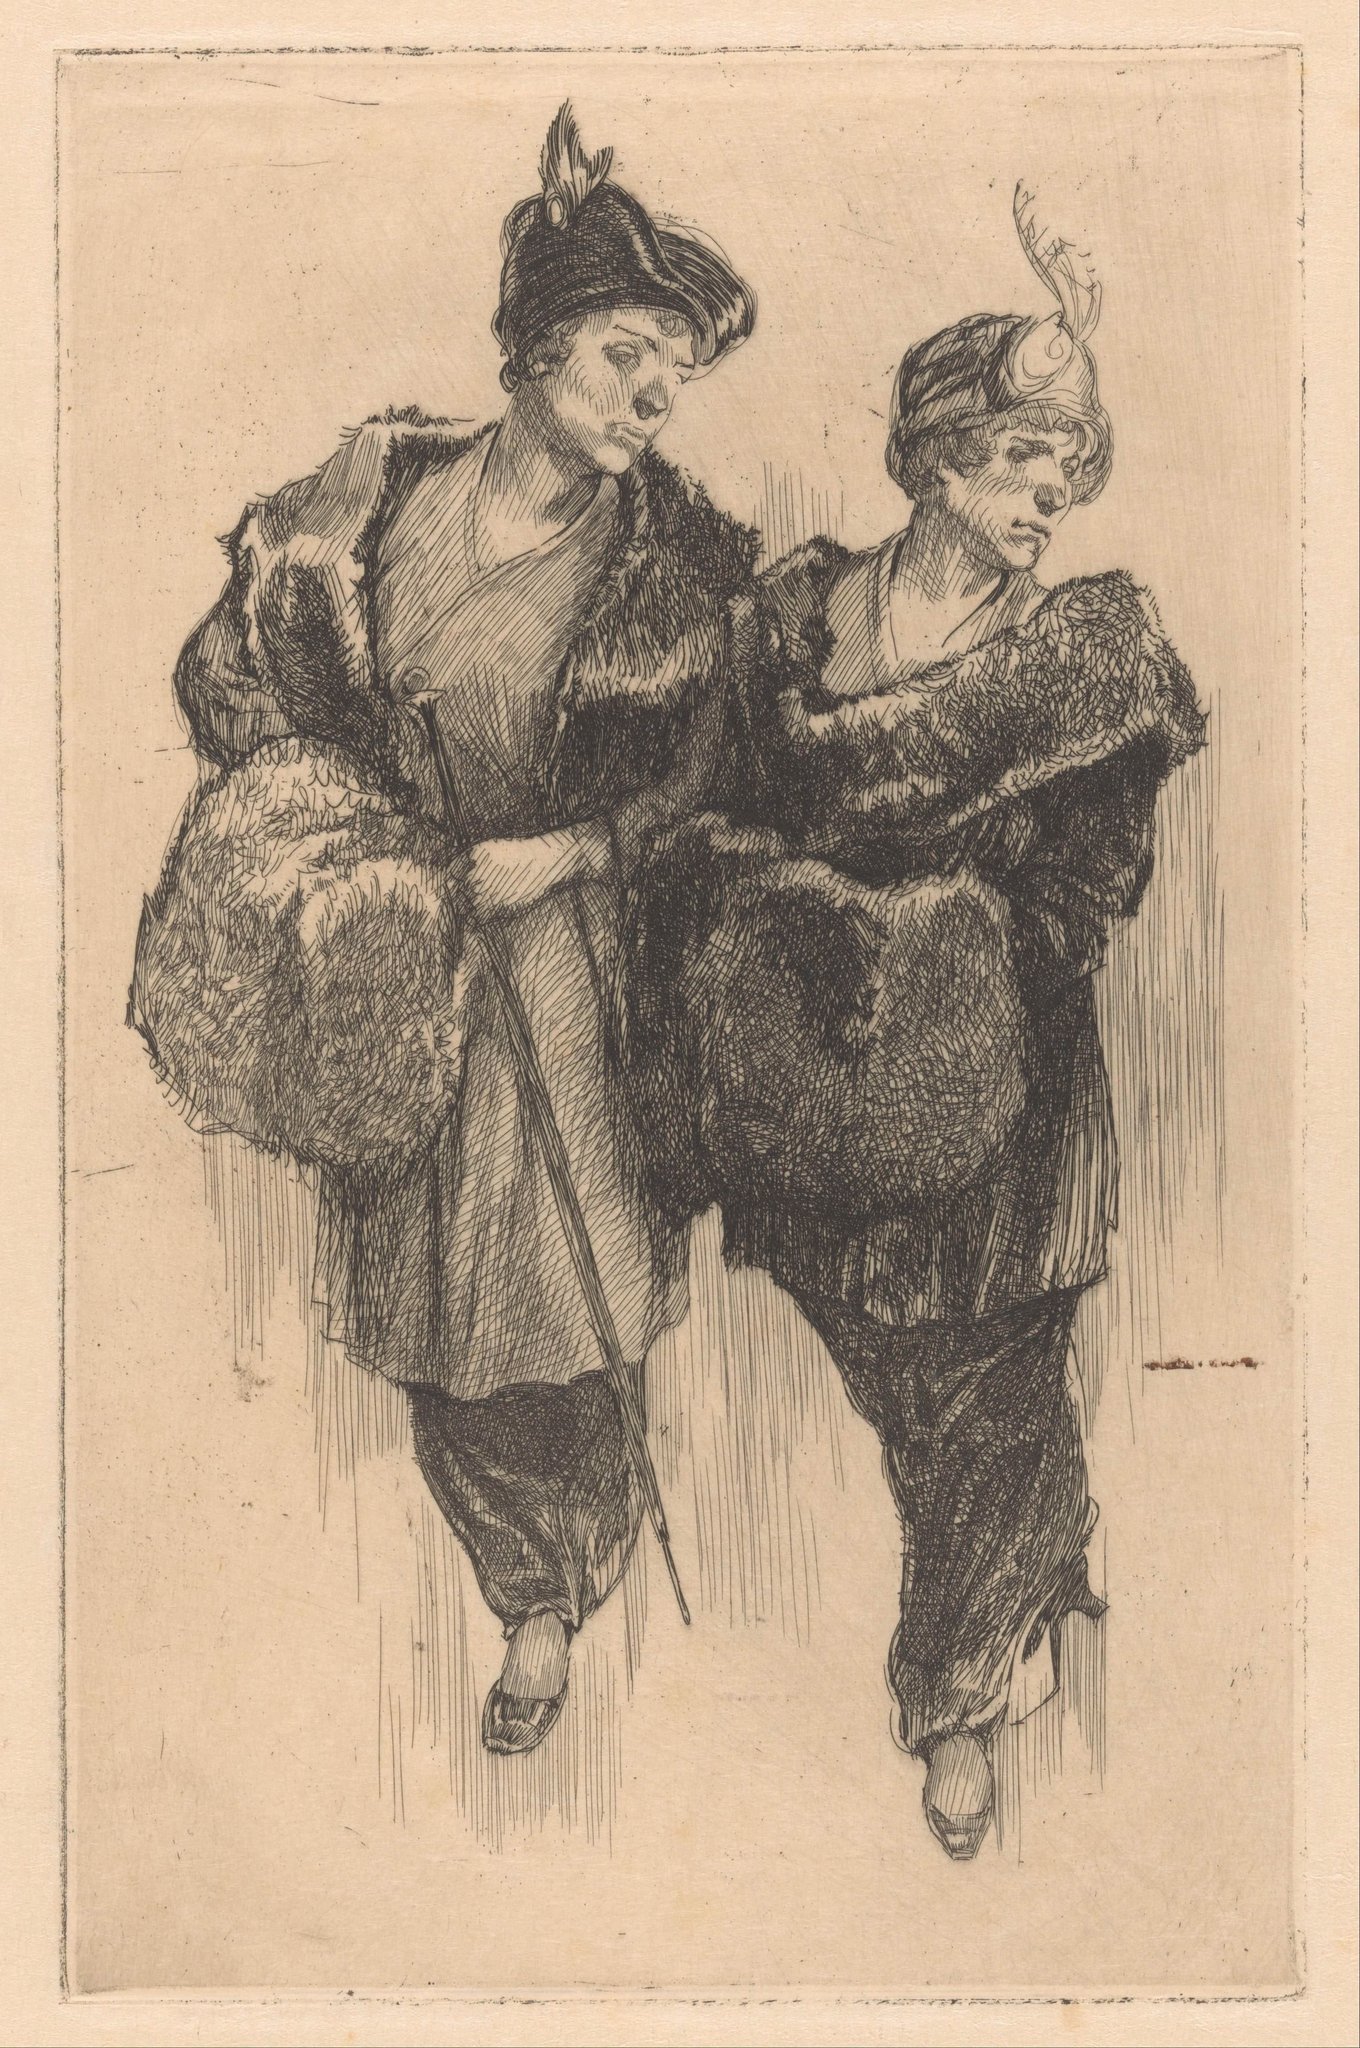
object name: print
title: Twee vrouwen in bont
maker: johannes josephus aarts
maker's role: draughtsman, print maker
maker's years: 1871-1934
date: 1912-1913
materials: paper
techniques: etching, intaglio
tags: muff, coat, walking-stick, staff, fashion, clothing (+ fur used for clothes)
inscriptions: collector's mark: Lugt 2228, collector's mark: Lugt 2760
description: Twee vrouwen gekleed in een jas met bontkraag. Beiden dragen een mof en een hoed met veer. Een van hen houdt een wandelstok vast.